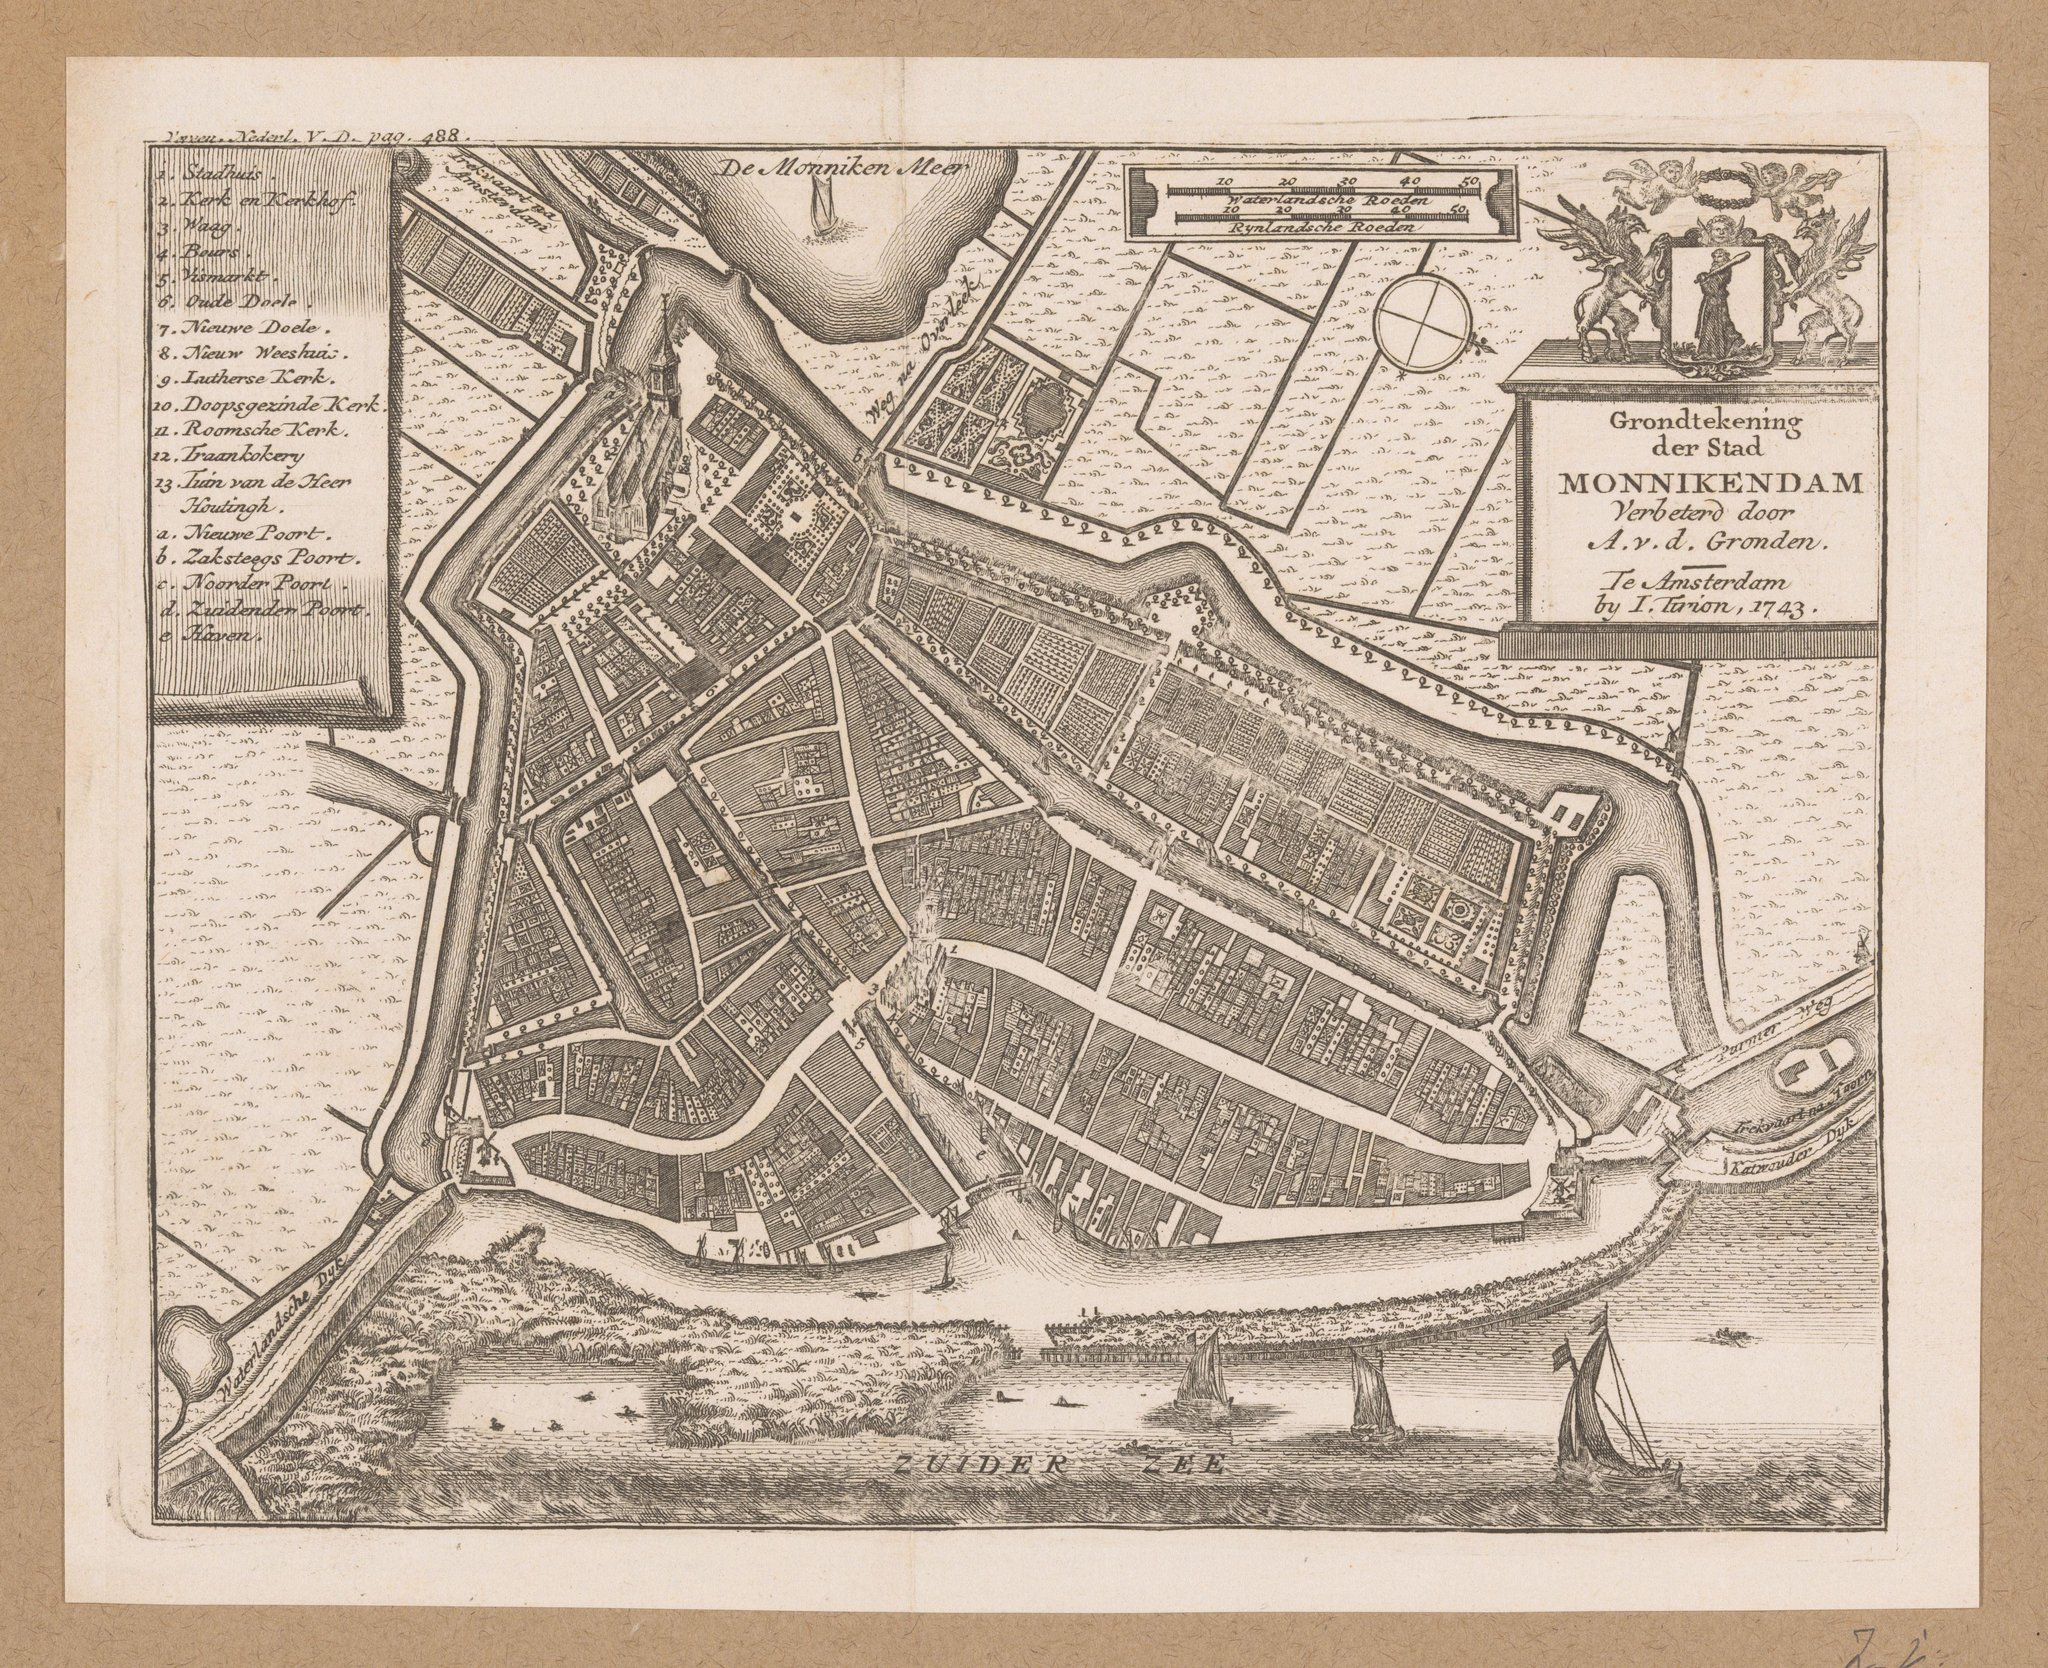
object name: book illustration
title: Plattegrond van Monnickendam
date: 1743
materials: paper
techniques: etching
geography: amsterdam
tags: maps of cities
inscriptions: date